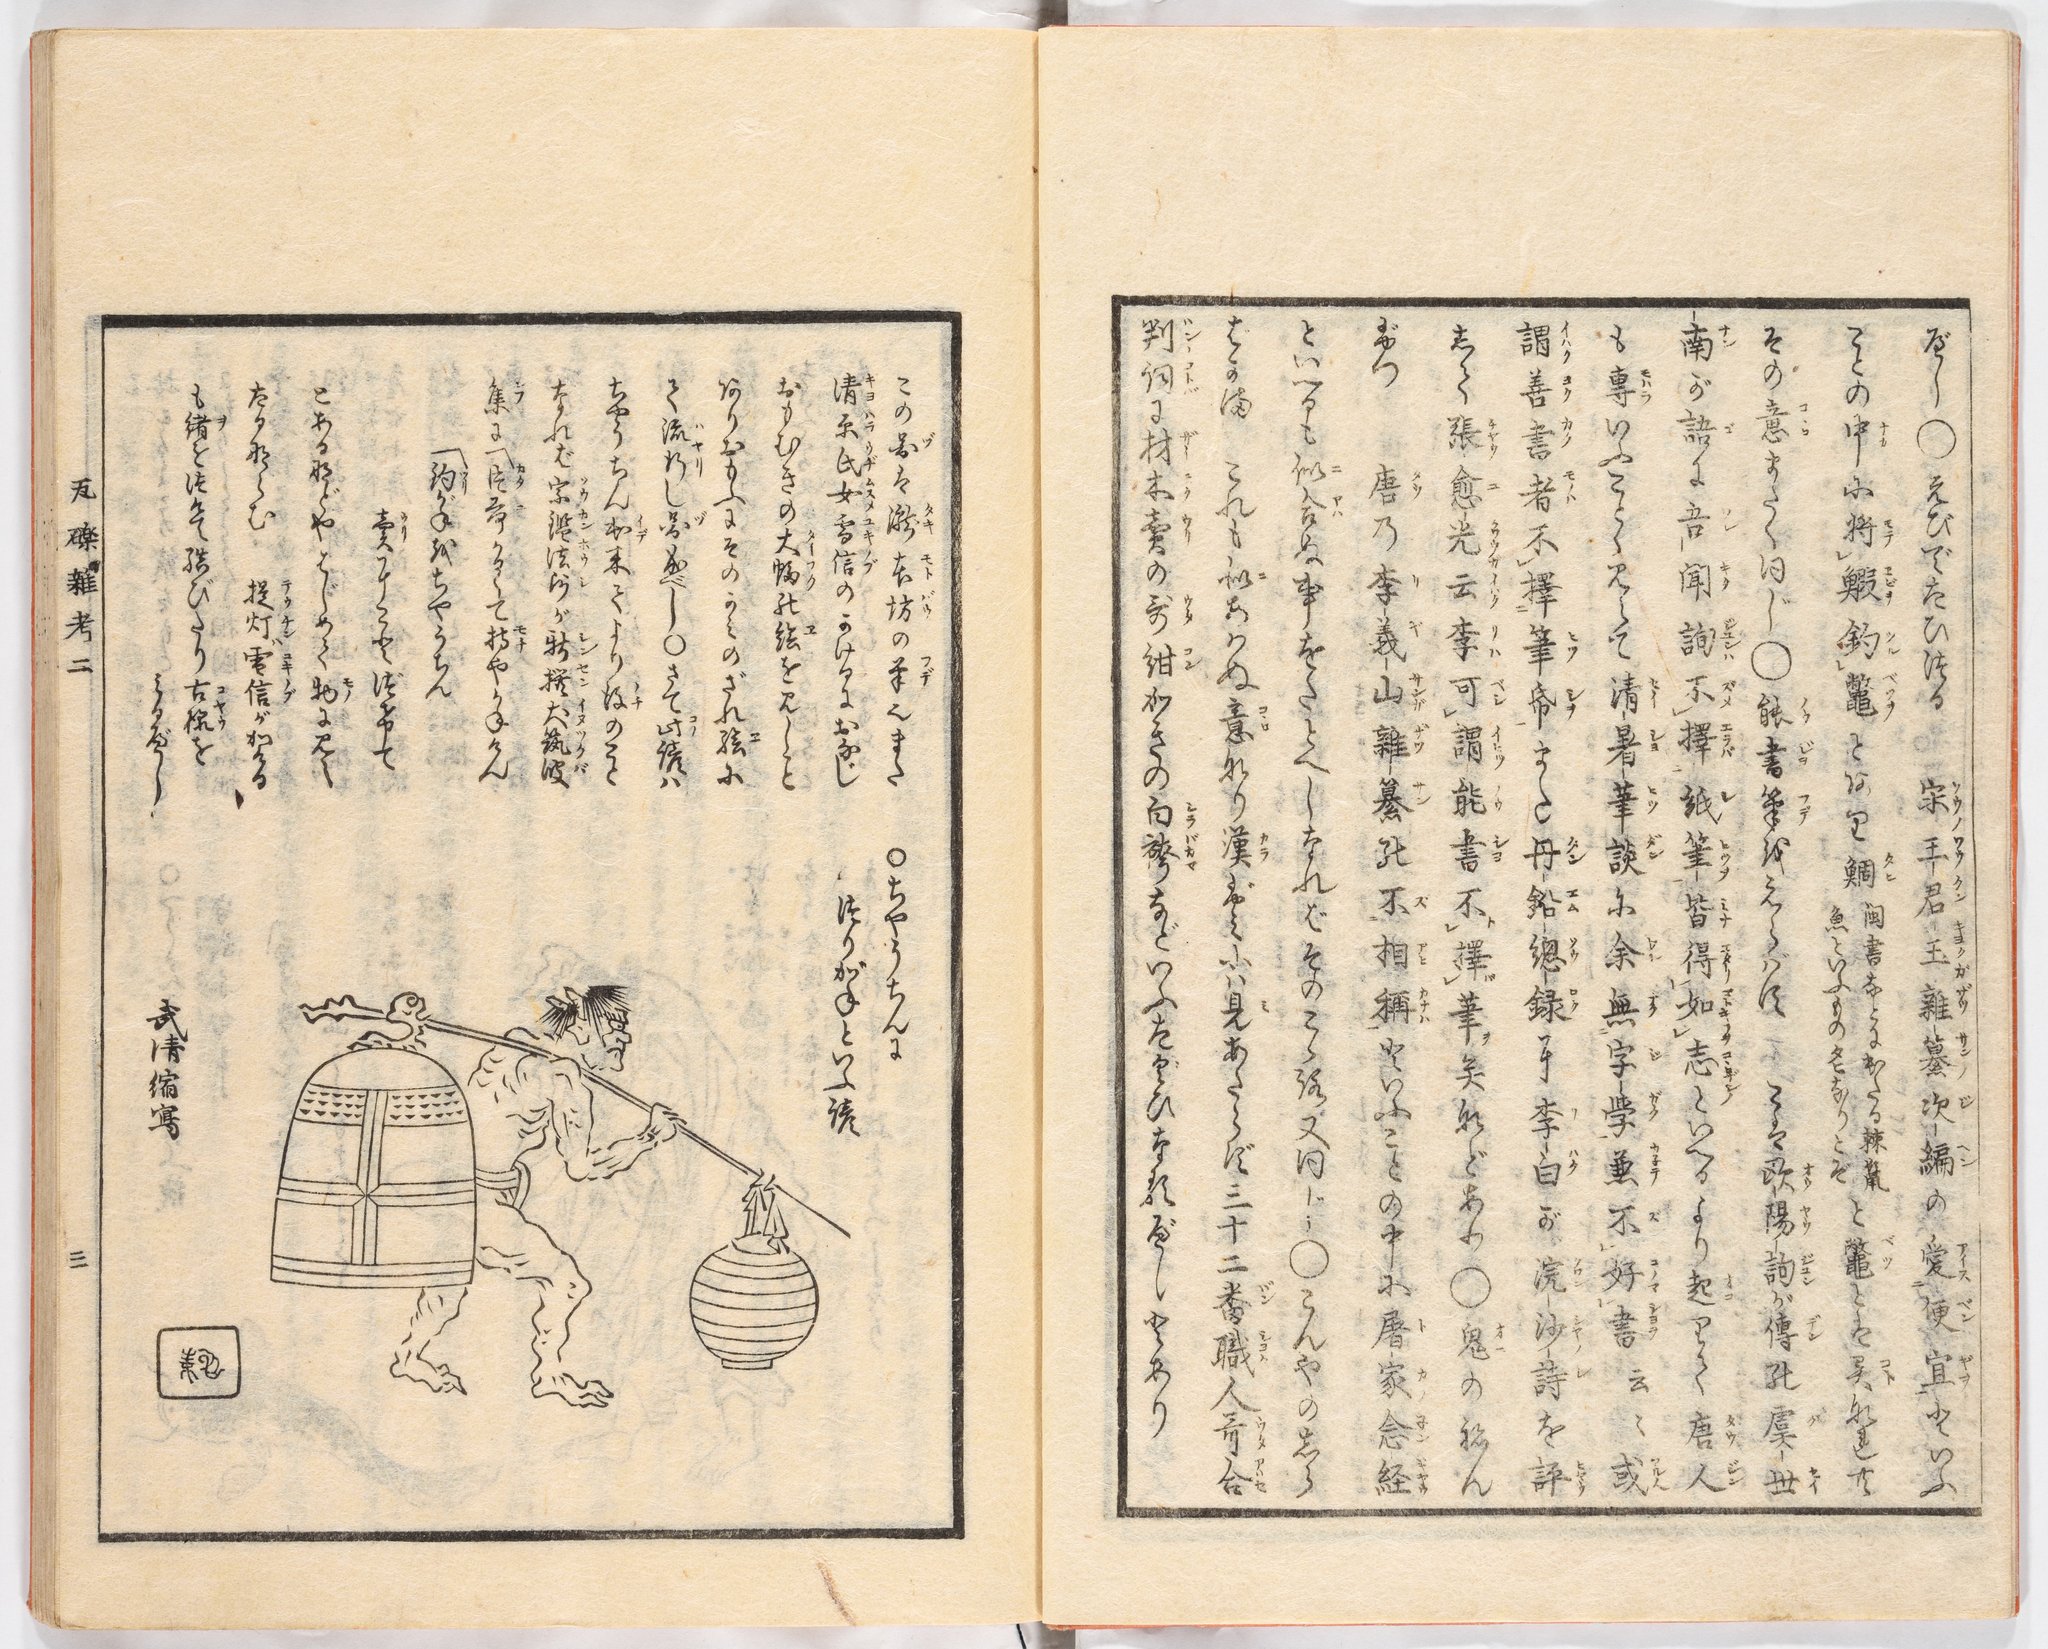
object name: illustrated book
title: Gareki zakko, Vol. 2 (notes on miscellaneous rubble)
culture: japanese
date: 1815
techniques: woodblock print